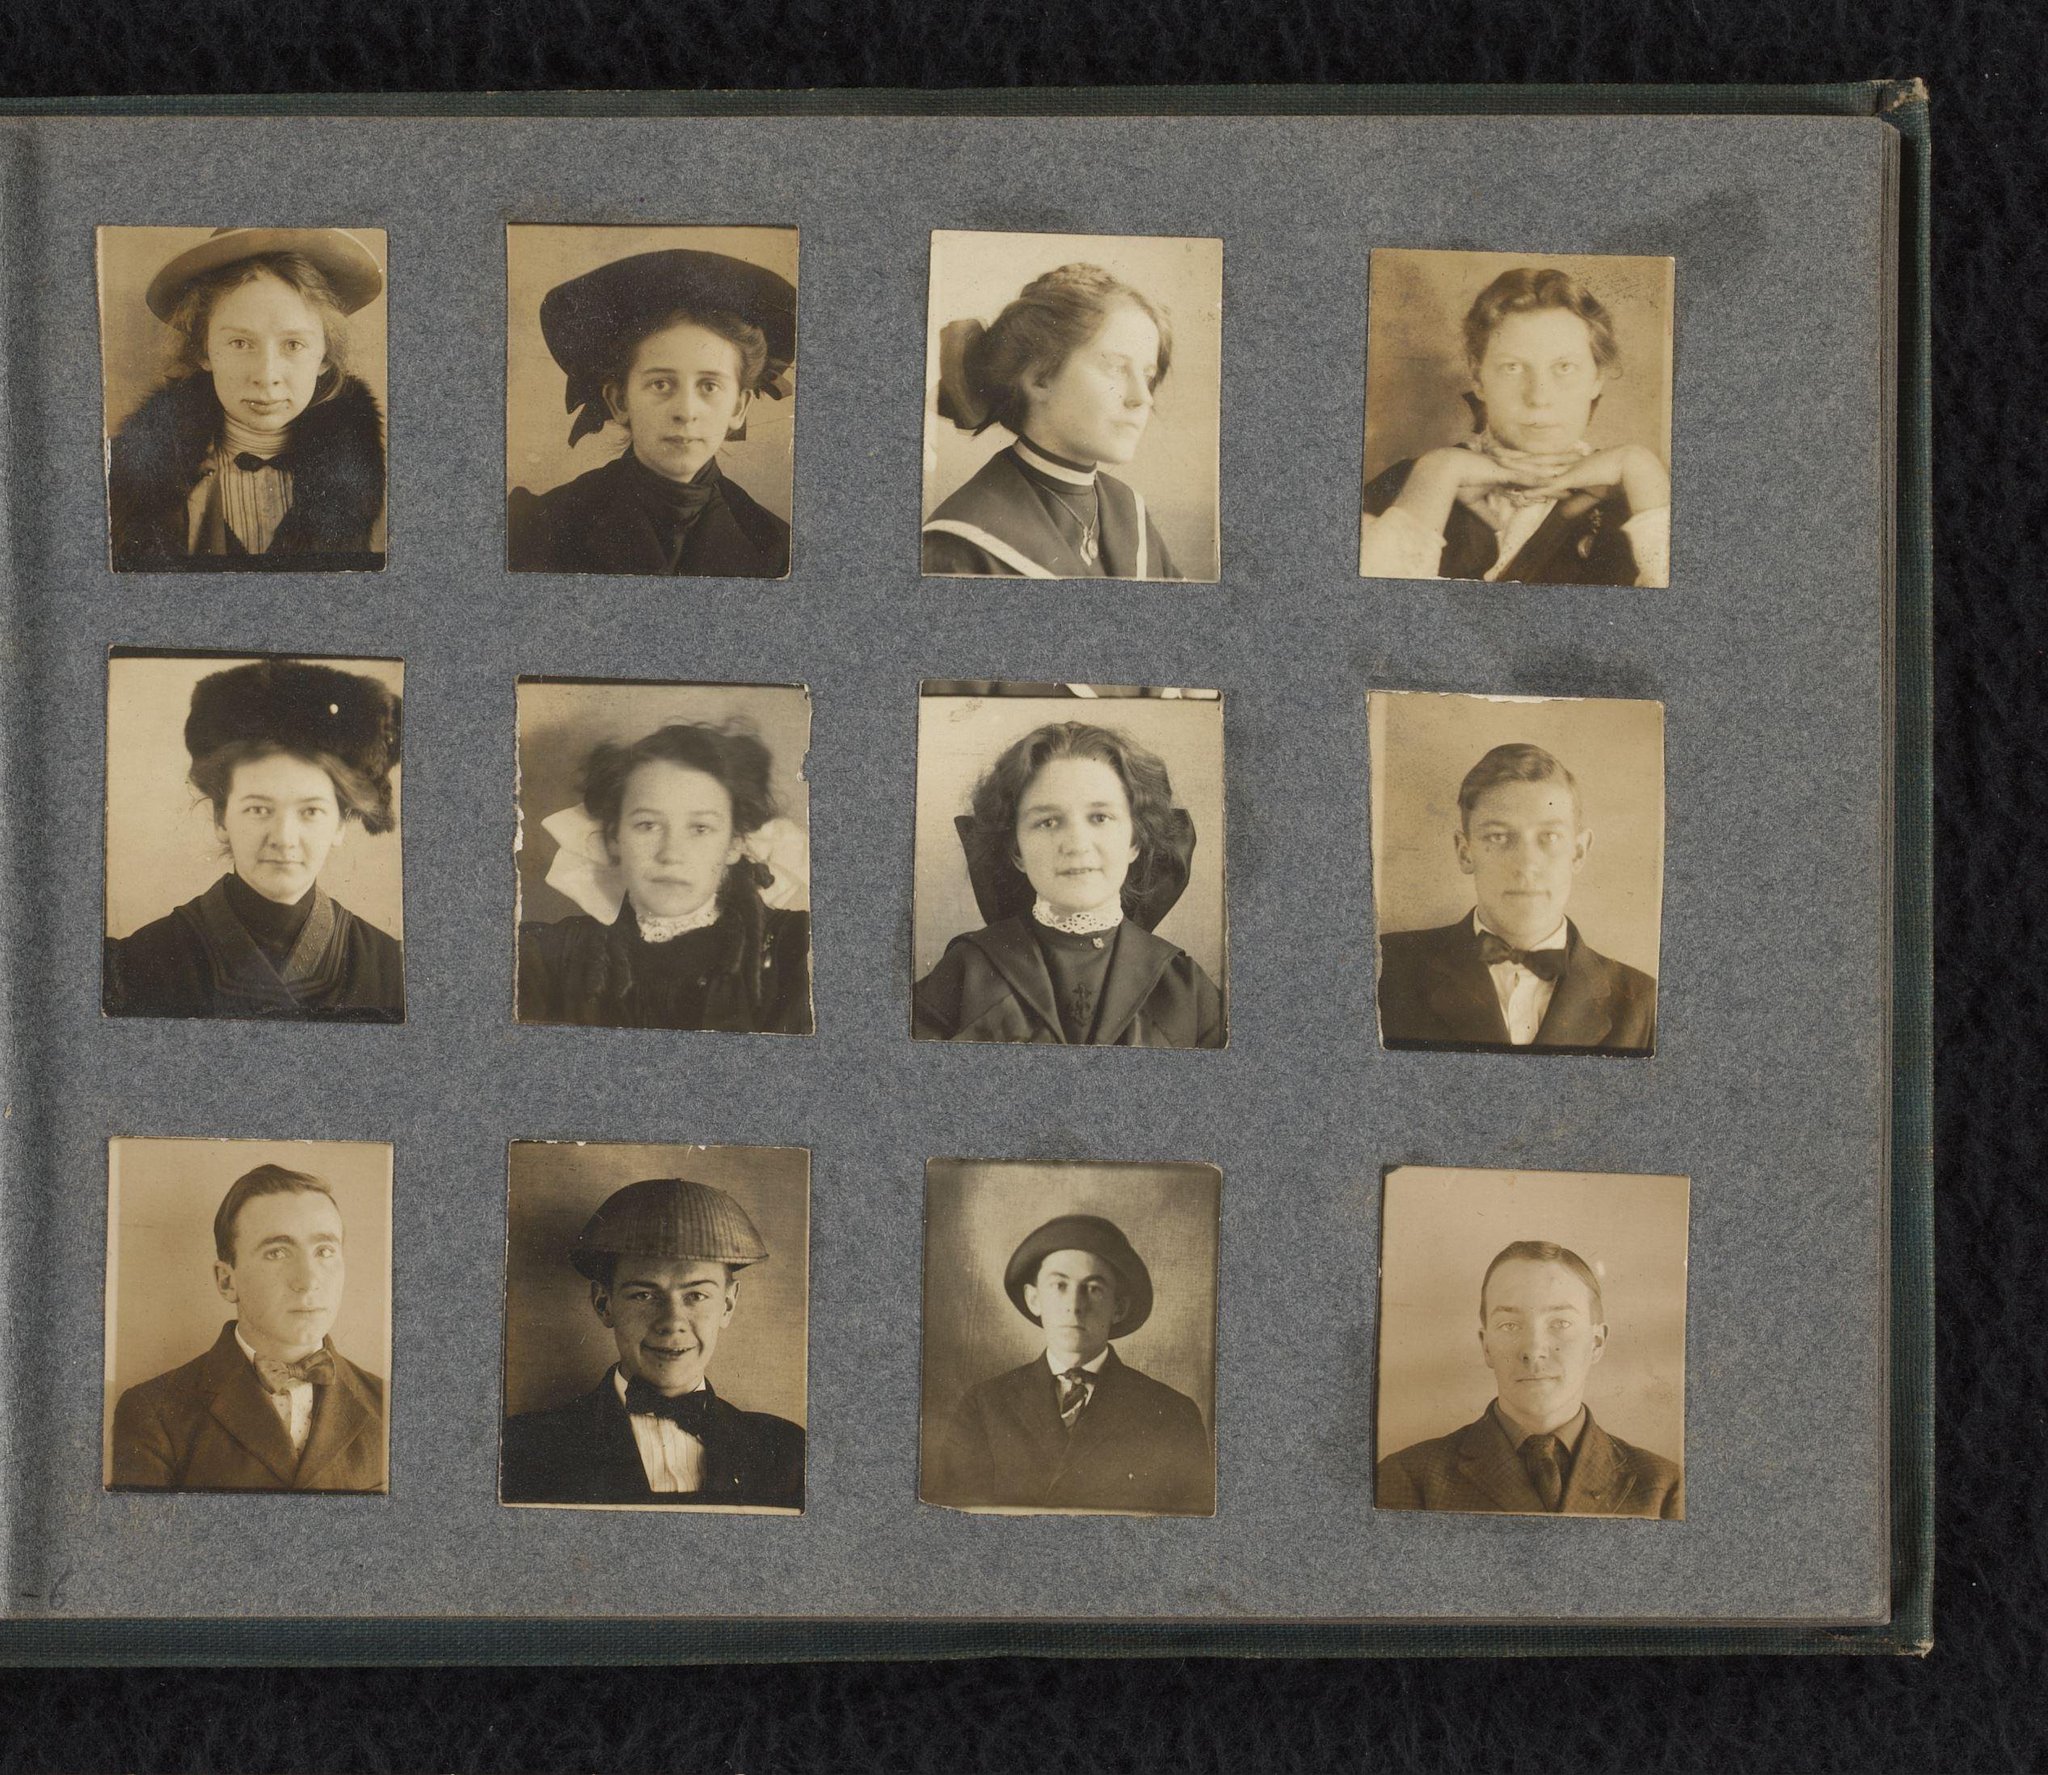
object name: album leaf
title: Twaalf portretten van onbekende meisjes en jongens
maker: Anonymous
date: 1905-1925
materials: paper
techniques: gelatin silver print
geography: united states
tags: historical persons not known by name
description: Deze foto's zijn onderdeel van een album.